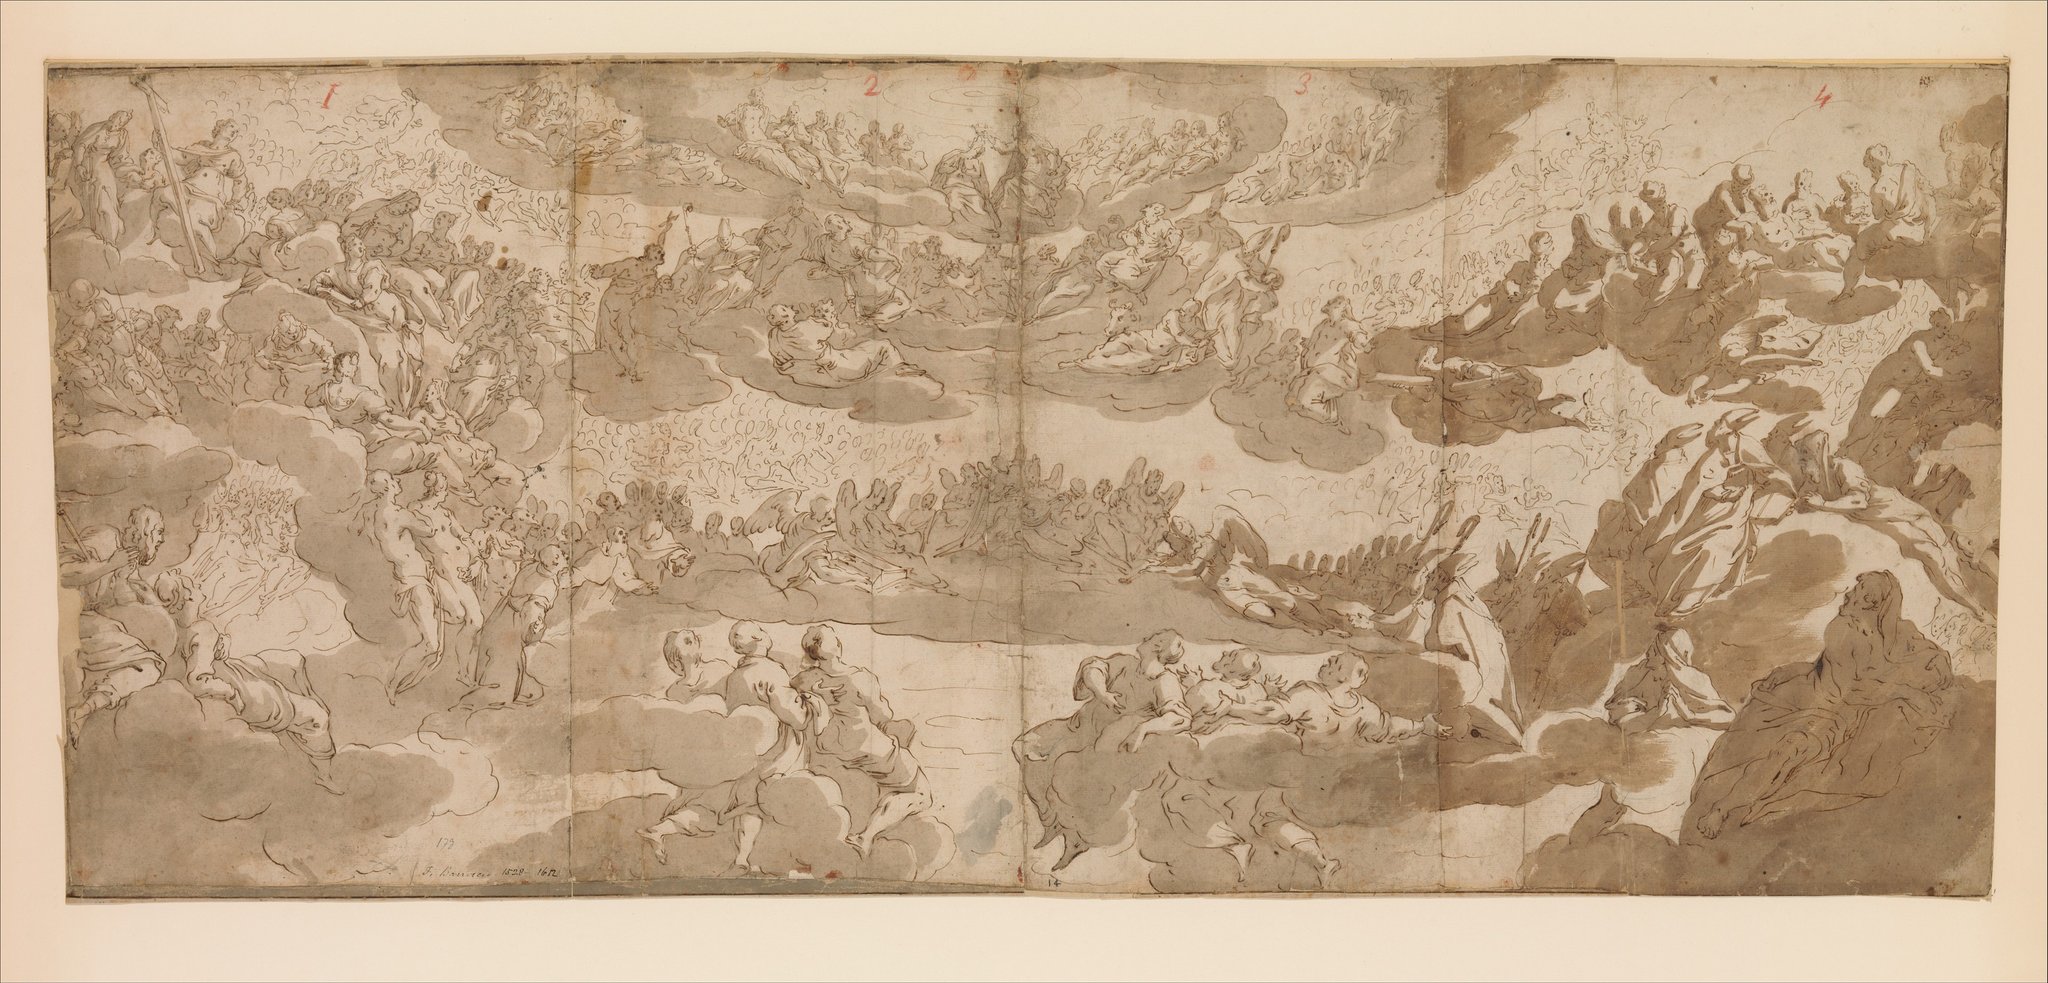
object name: drawing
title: Paradise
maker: jacopo tintoretto (jacopo robusti)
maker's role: artist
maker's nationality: italian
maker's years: 1518-1594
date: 1519-1594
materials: ink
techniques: pen, wash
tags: human figures,angels